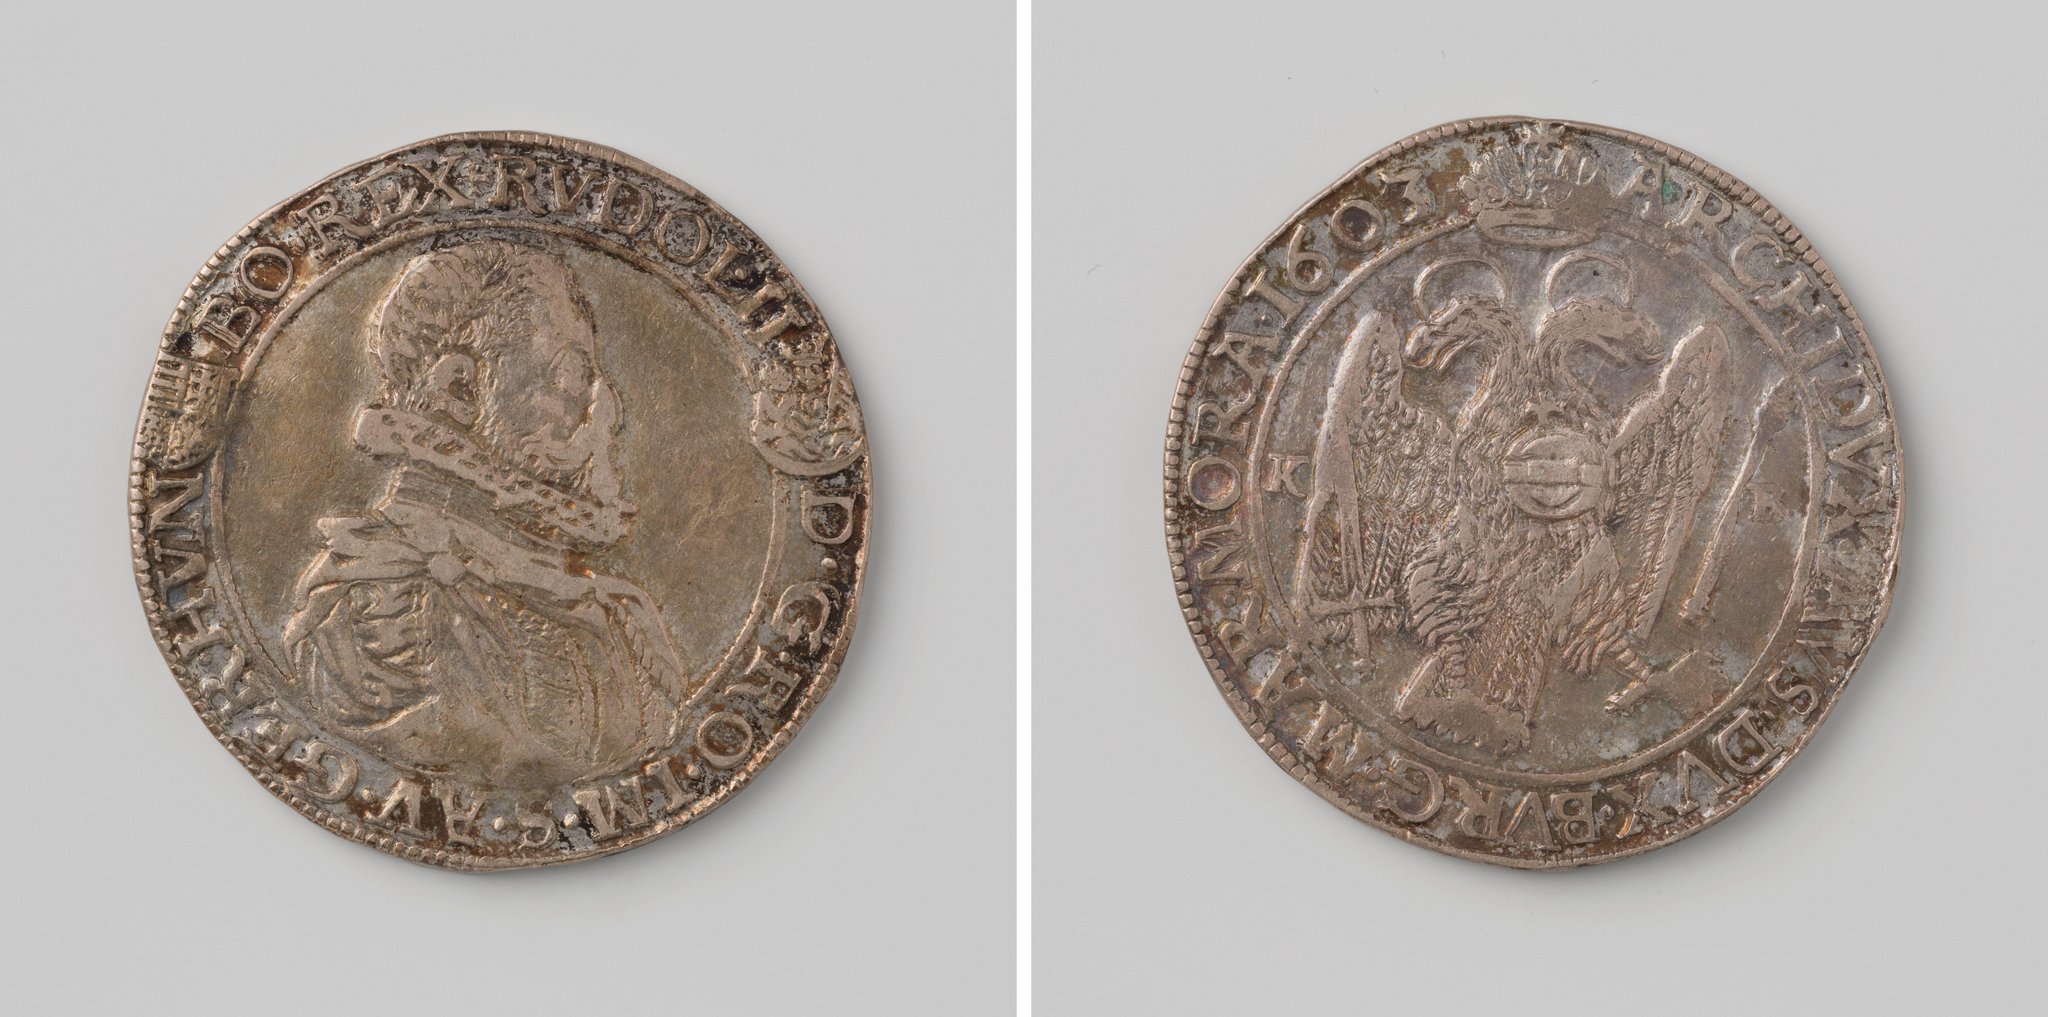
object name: coin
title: Hongarije, Moravië, keizer Rudolph II, taler,1603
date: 1603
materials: silver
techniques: striking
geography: kremnica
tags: rudolf ii van habsburg (duits keizer)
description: Zilveren munt. Voorzijde: tussen twee wapenschilden geharnast borstbeeld met kraag van de keizer naar rechts. Keerzijde: tussen letters N en B [=Kremnitz] gekroonde dubbelkoppige adelaar met rijksappel, waarin wapenschild op de borst en in zijn poten een zwaard en een scepter. Jaartal aan het eind van het omschrift.